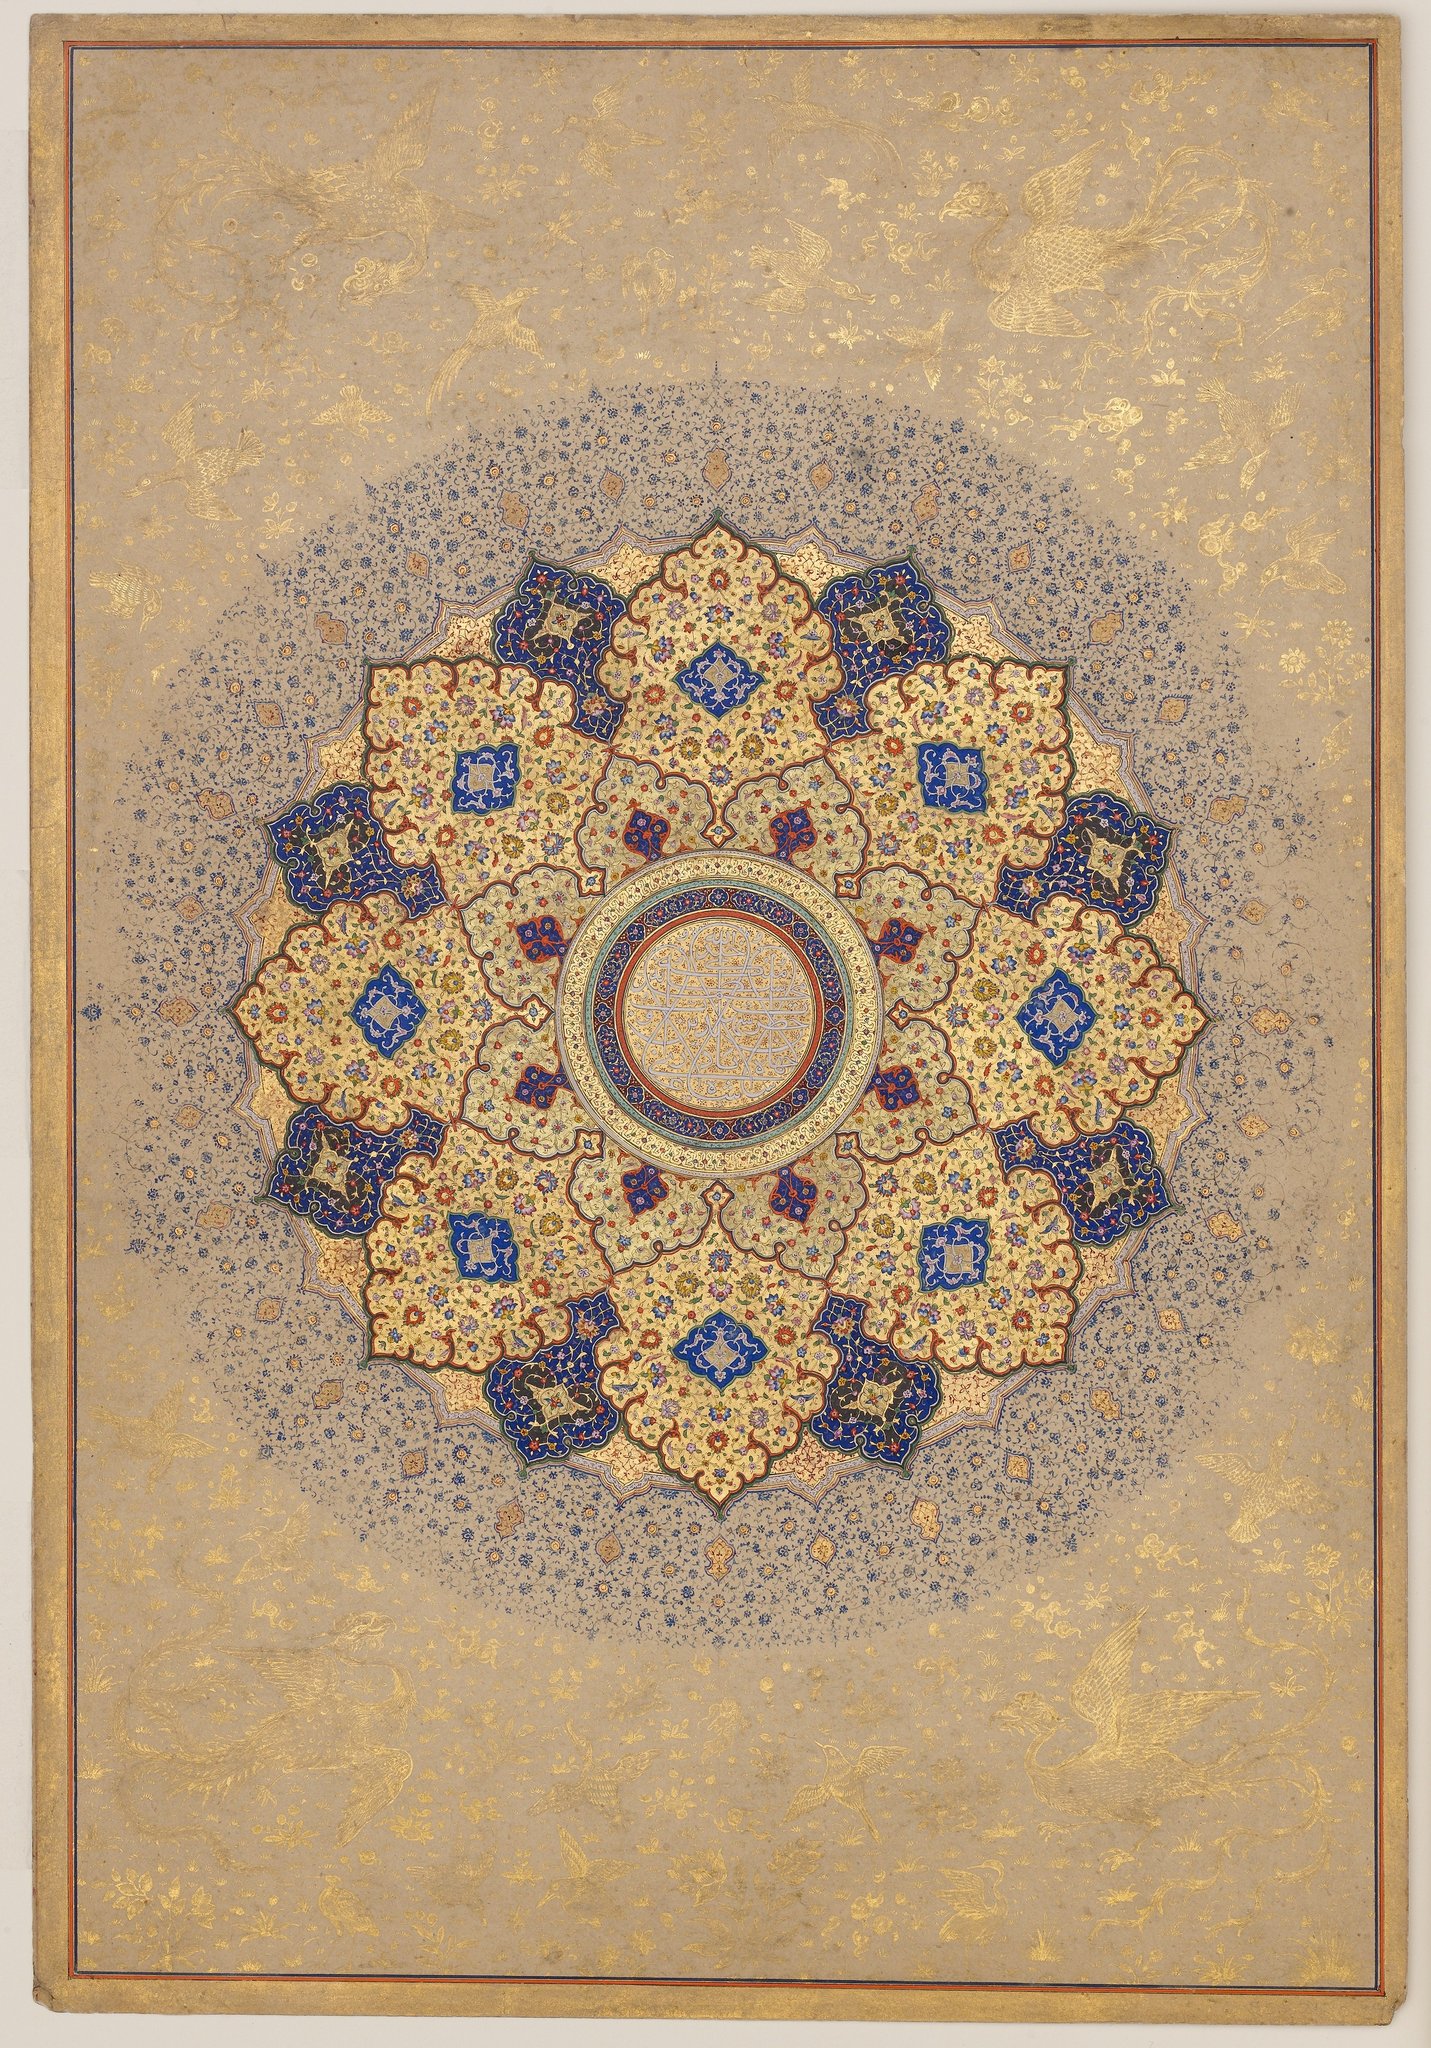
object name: album leaf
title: "Rosette Bearing the Names and Titles of Shah Jahan", Folio from the Shah Jahan Album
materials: gold, ink, paper, watercolor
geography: india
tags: calligraphy